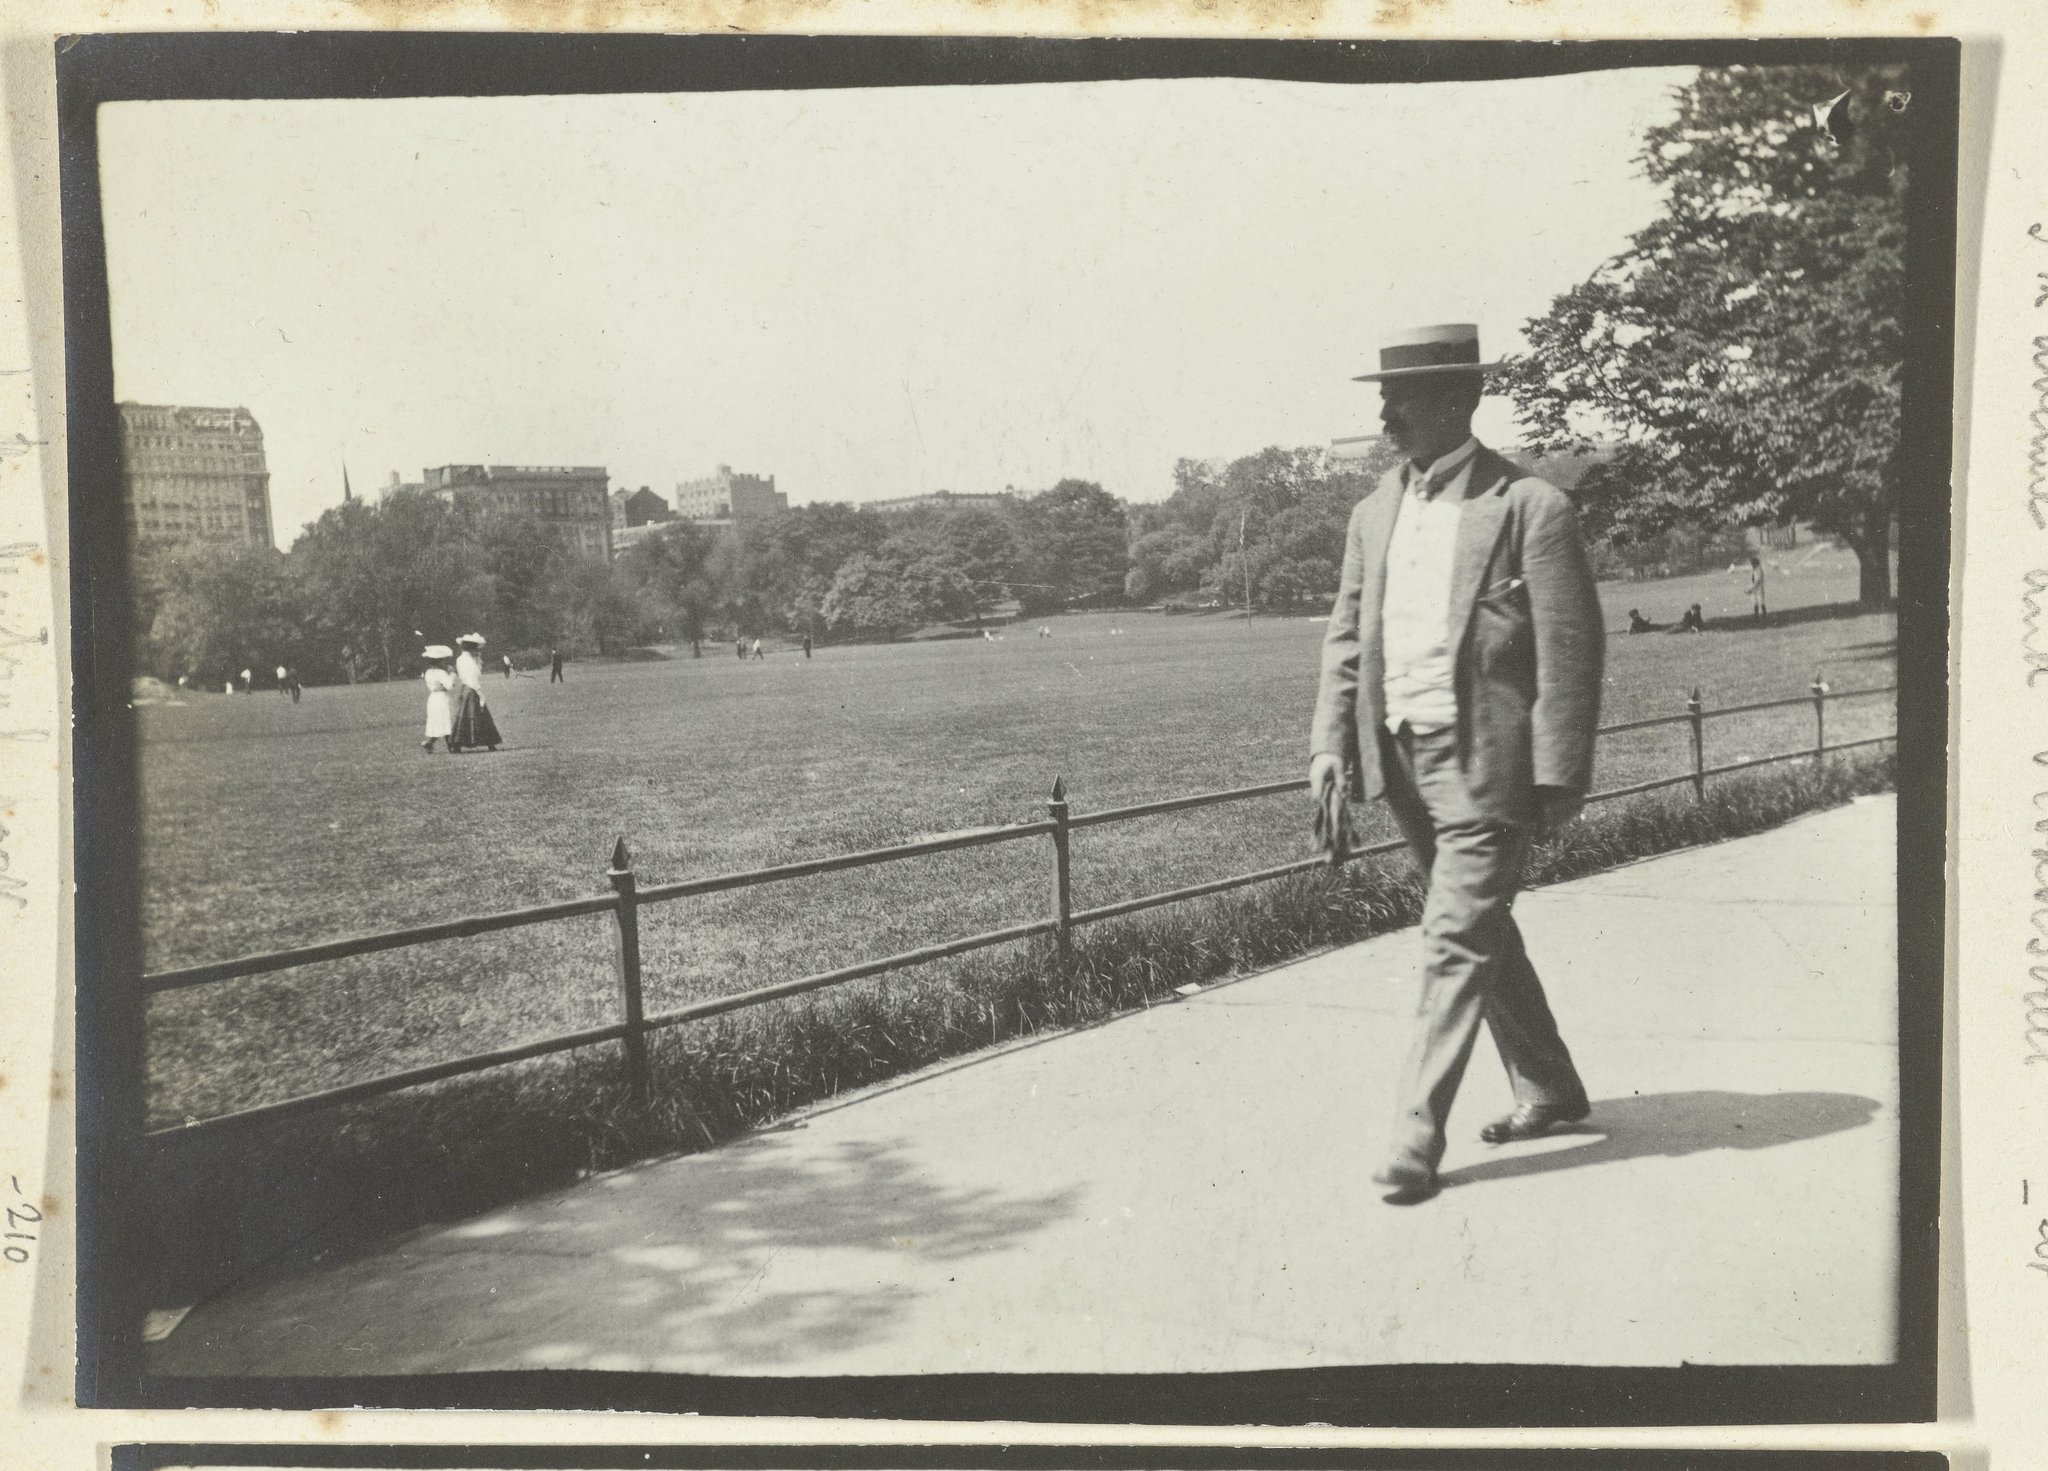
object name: photograph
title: In the Central Park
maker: geldolph adriaan kessler (dolph)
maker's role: fotograaf, industrieel, voetballer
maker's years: 1884-1945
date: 1905-1908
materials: cardboard, photographic support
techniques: gelatin silver print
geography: new york city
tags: central park (new york)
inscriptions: title: ‘In the Central Park’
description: Vermoedelijk een reisgenoot van Dolph Kessler in Central Park New York. Onderdeel van het fotoalbum van Dolph Kessler met opnamen die hij maakte tijdens zijn verblijf in Engeland en op een wereldreis die hij als secretaris van Henri Deterding (directeur Koninklijke Olie) ondernam naar Nederlands-Indië, Japan, China en de Verenigde Staten, tussen 1906 en 1908.